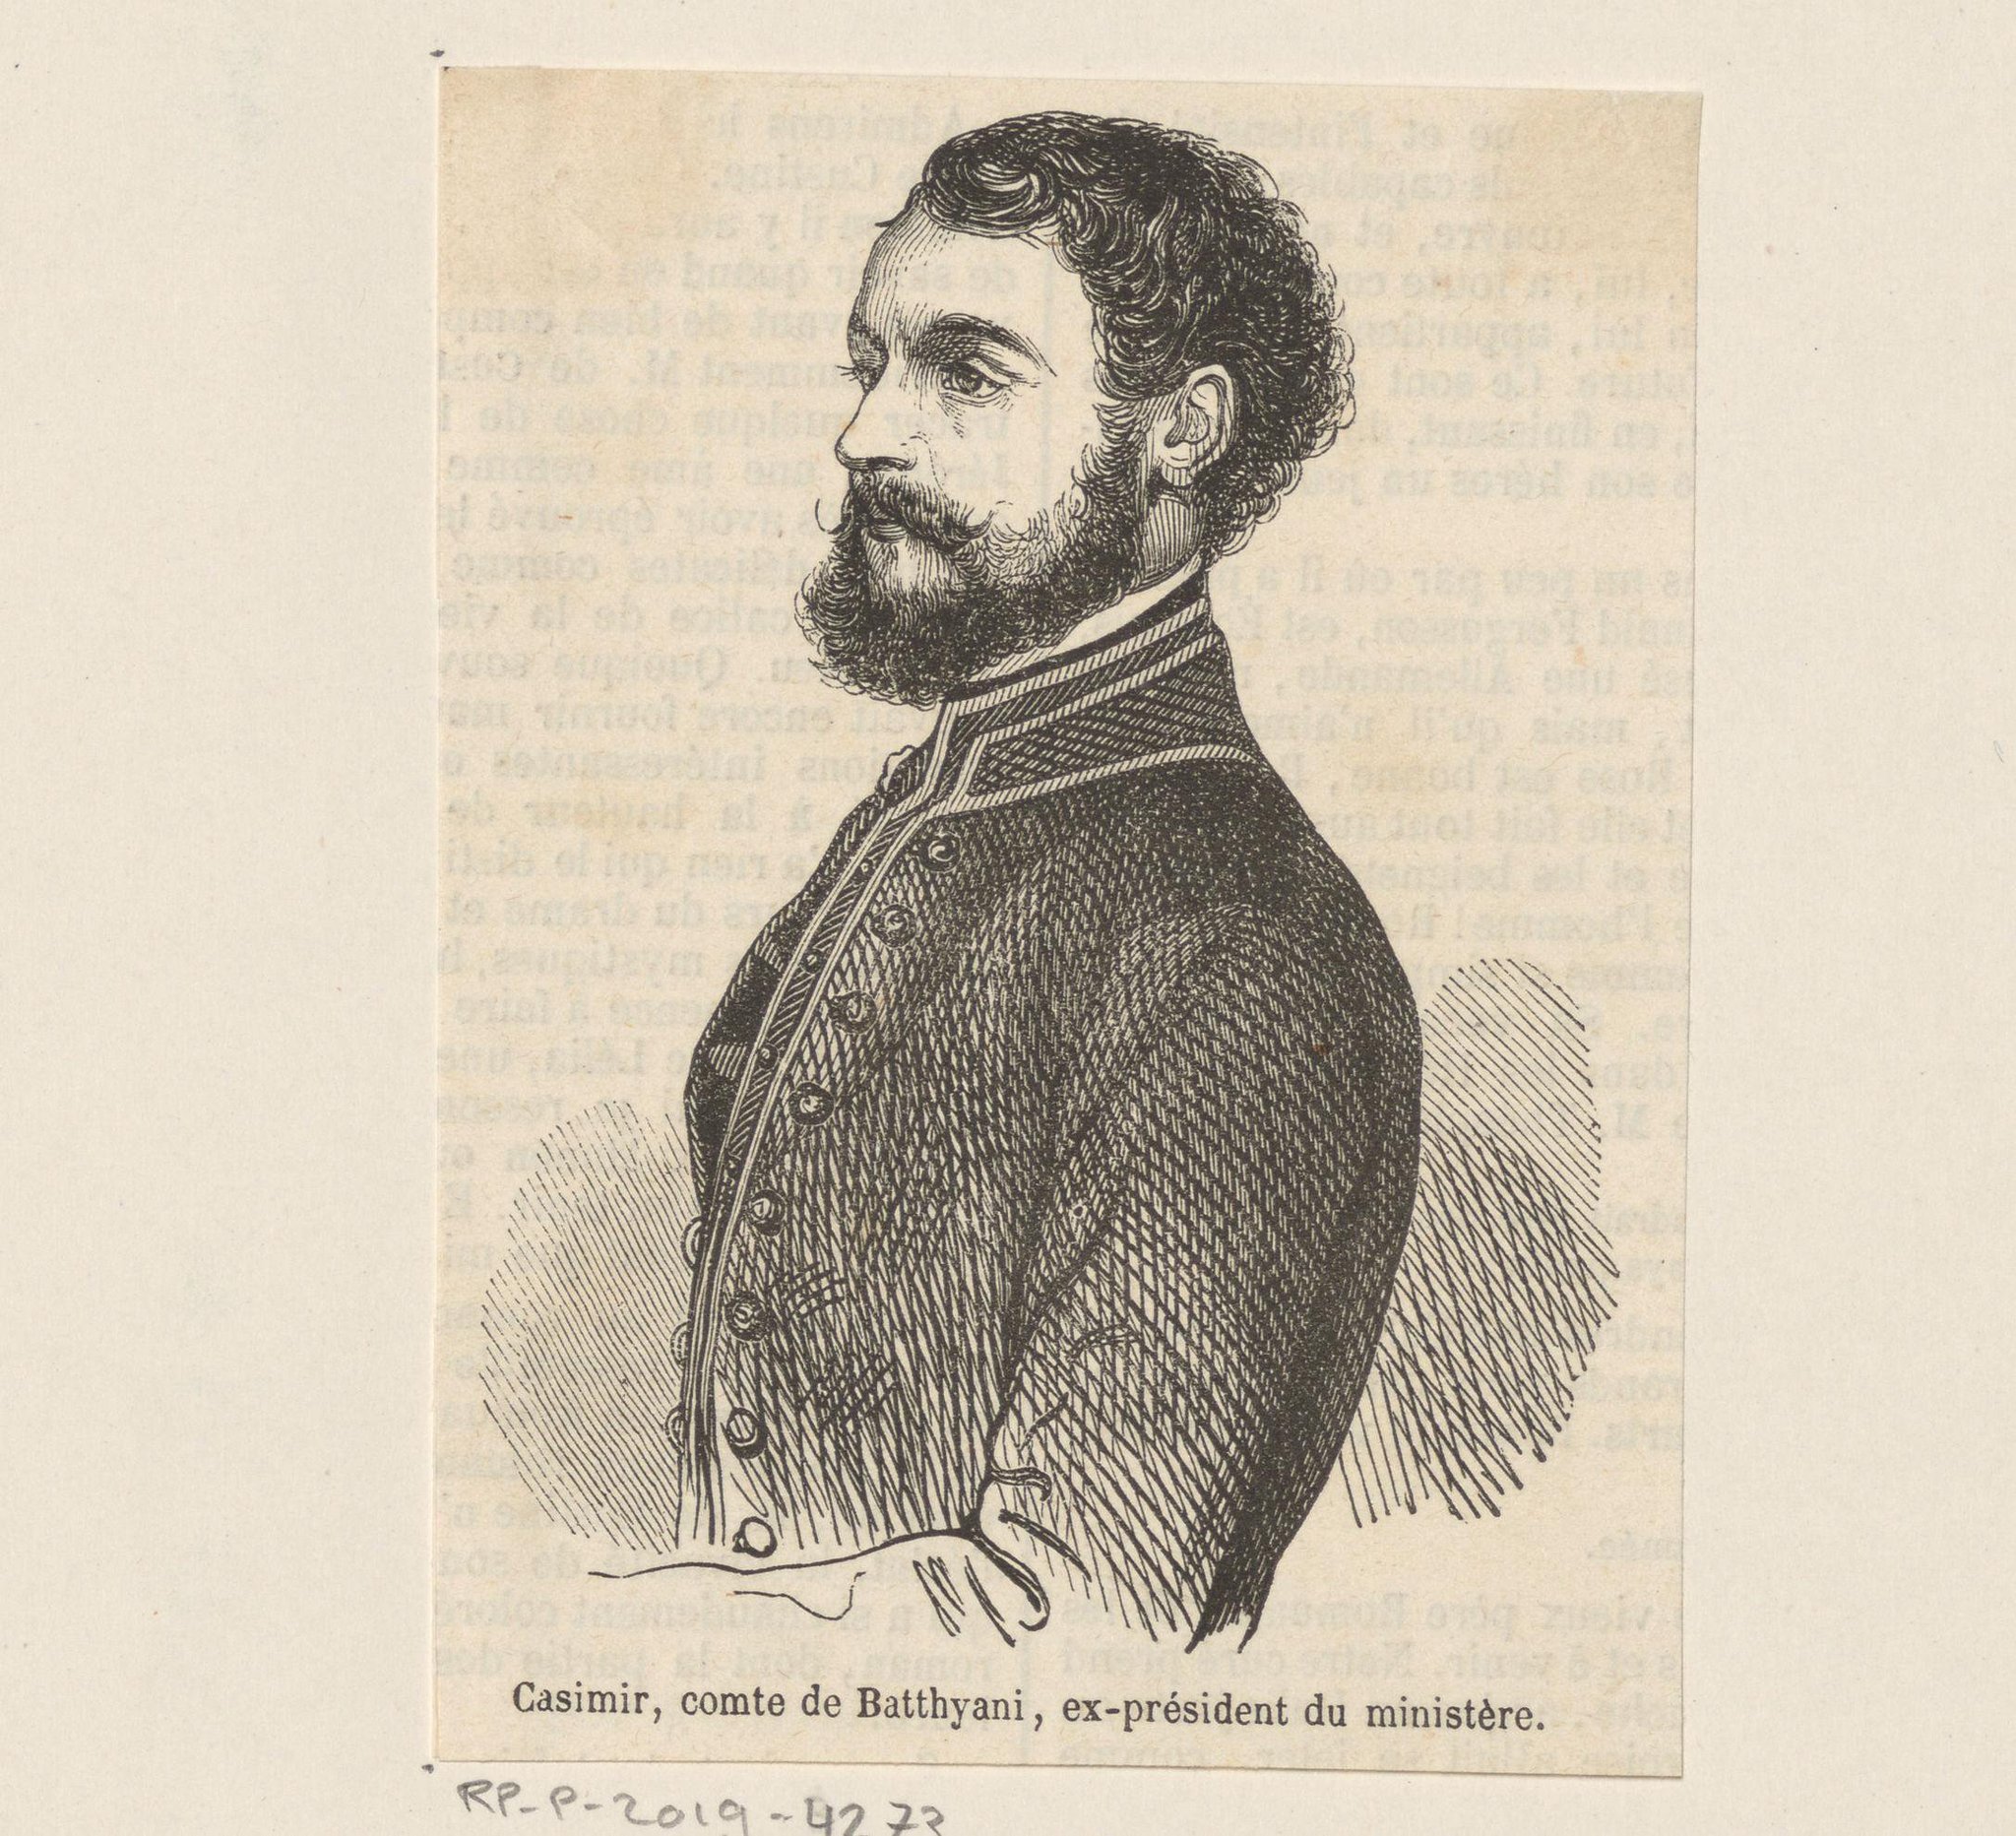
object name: book illustration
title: Portret van Kázmér Batthyány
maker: Anonymous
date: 1848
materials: paper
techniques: letterpress printing, line block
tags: politician, historical persons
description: Prent uit: L'Illustration, journal universel (1848).